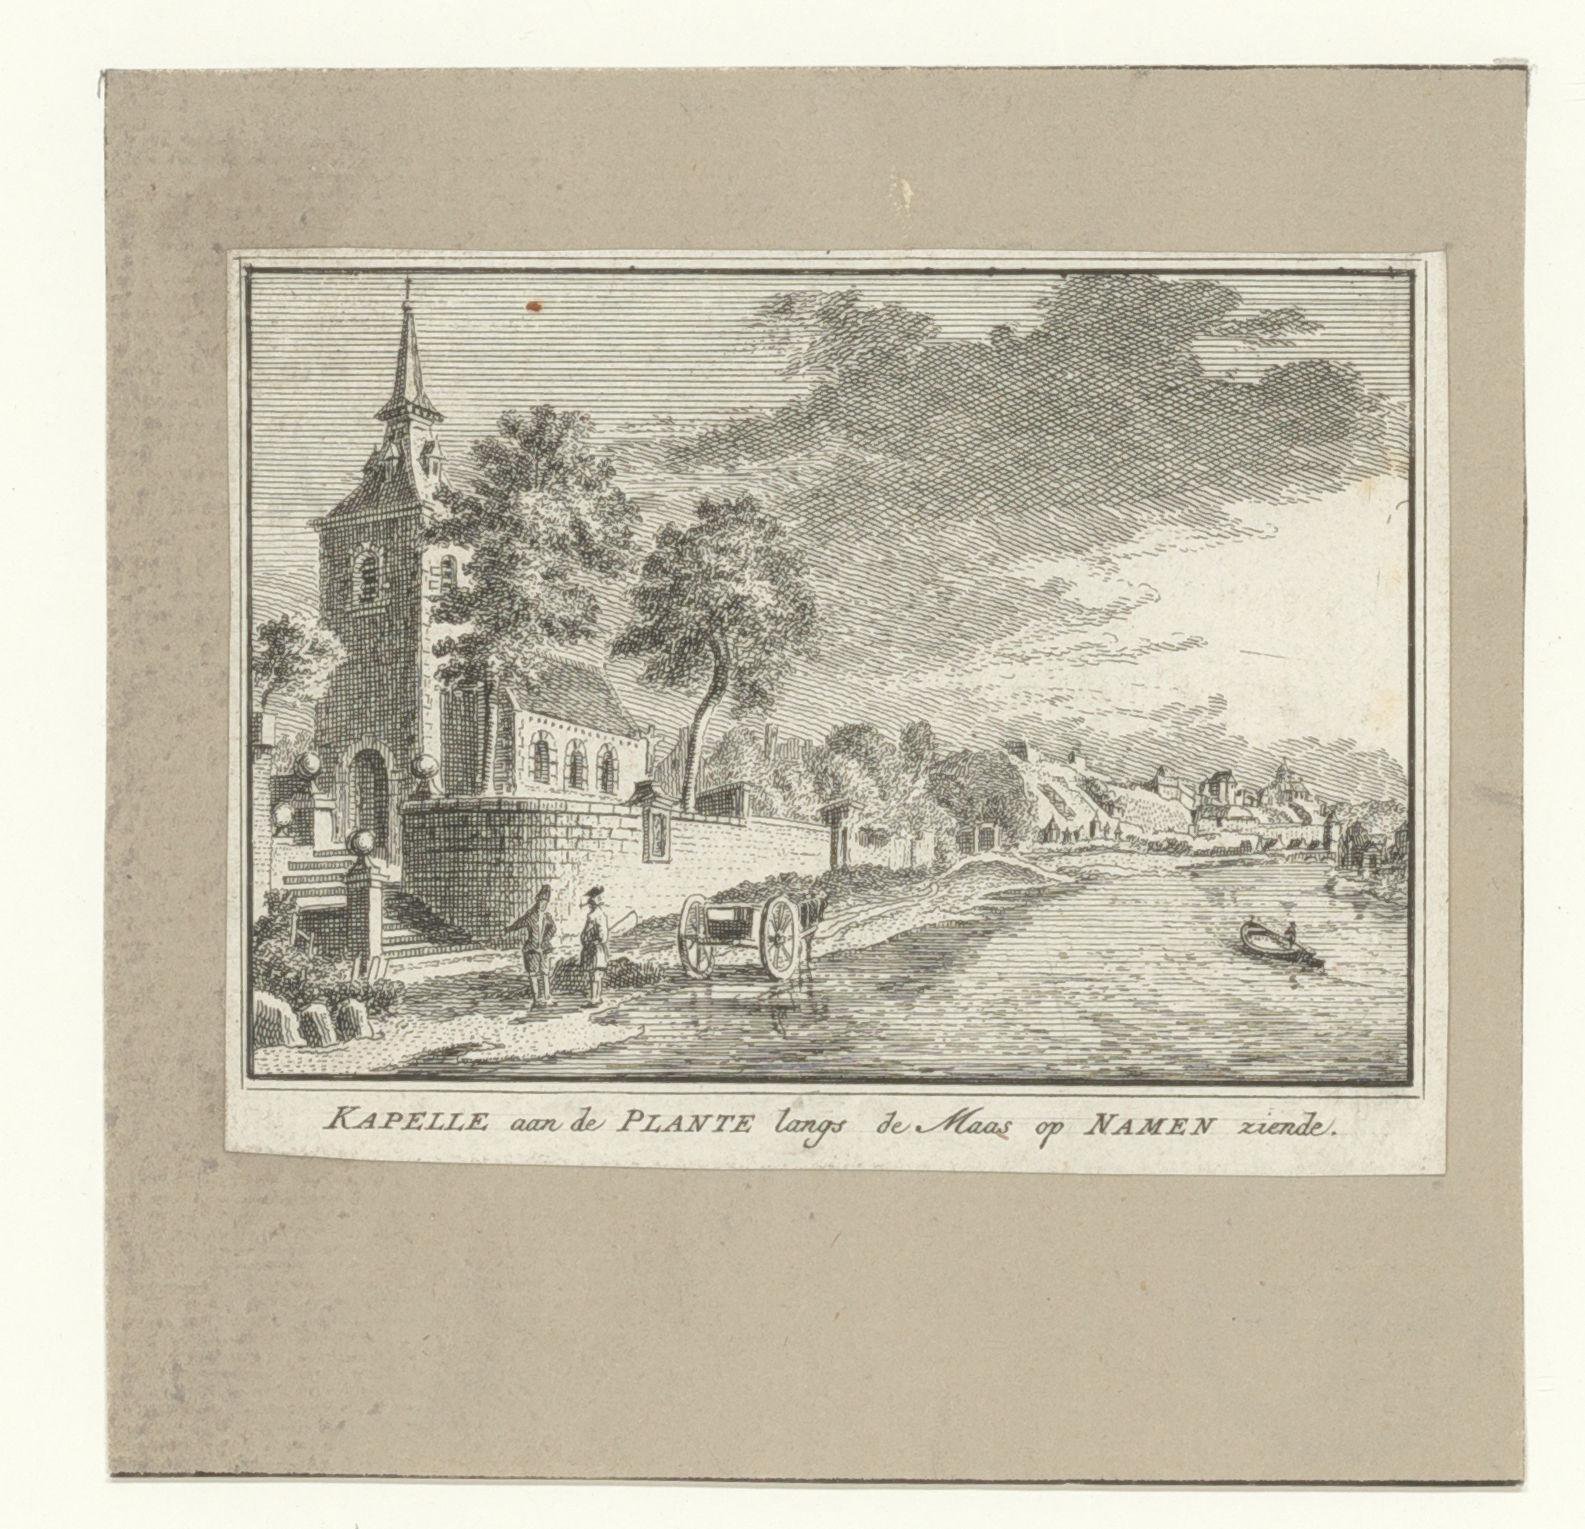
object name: book illustration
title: Gezicht op een kapel in het gehucht La Plante, aan de Maas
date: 1746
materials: paper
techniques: engraving, etching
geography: haarlem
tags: river, church (exterior) - qq - small church, chapel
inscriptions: collector's mark, collector's mark: Lugt 1641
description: Prent eerst gebruikt in: Het verheerlykt Nederland of kabinet van hedendaagsche gezigten van steden, dorpen (…). 9 delen. Amsterdam: Isaak Tirion en weduwe Isaak Tirion, 1745-1774, dl. 2 (1746), ill. 117-118. Later ook in: Nederlandsche tafereelen; of eene keurige verzameling van negen honderd fraaije gezigten van steden, dorpen, sloten, oudheden (…). 9 delen. Amsterdam: Jan de Groot, 1792, dl. 2, ill. 117-118.